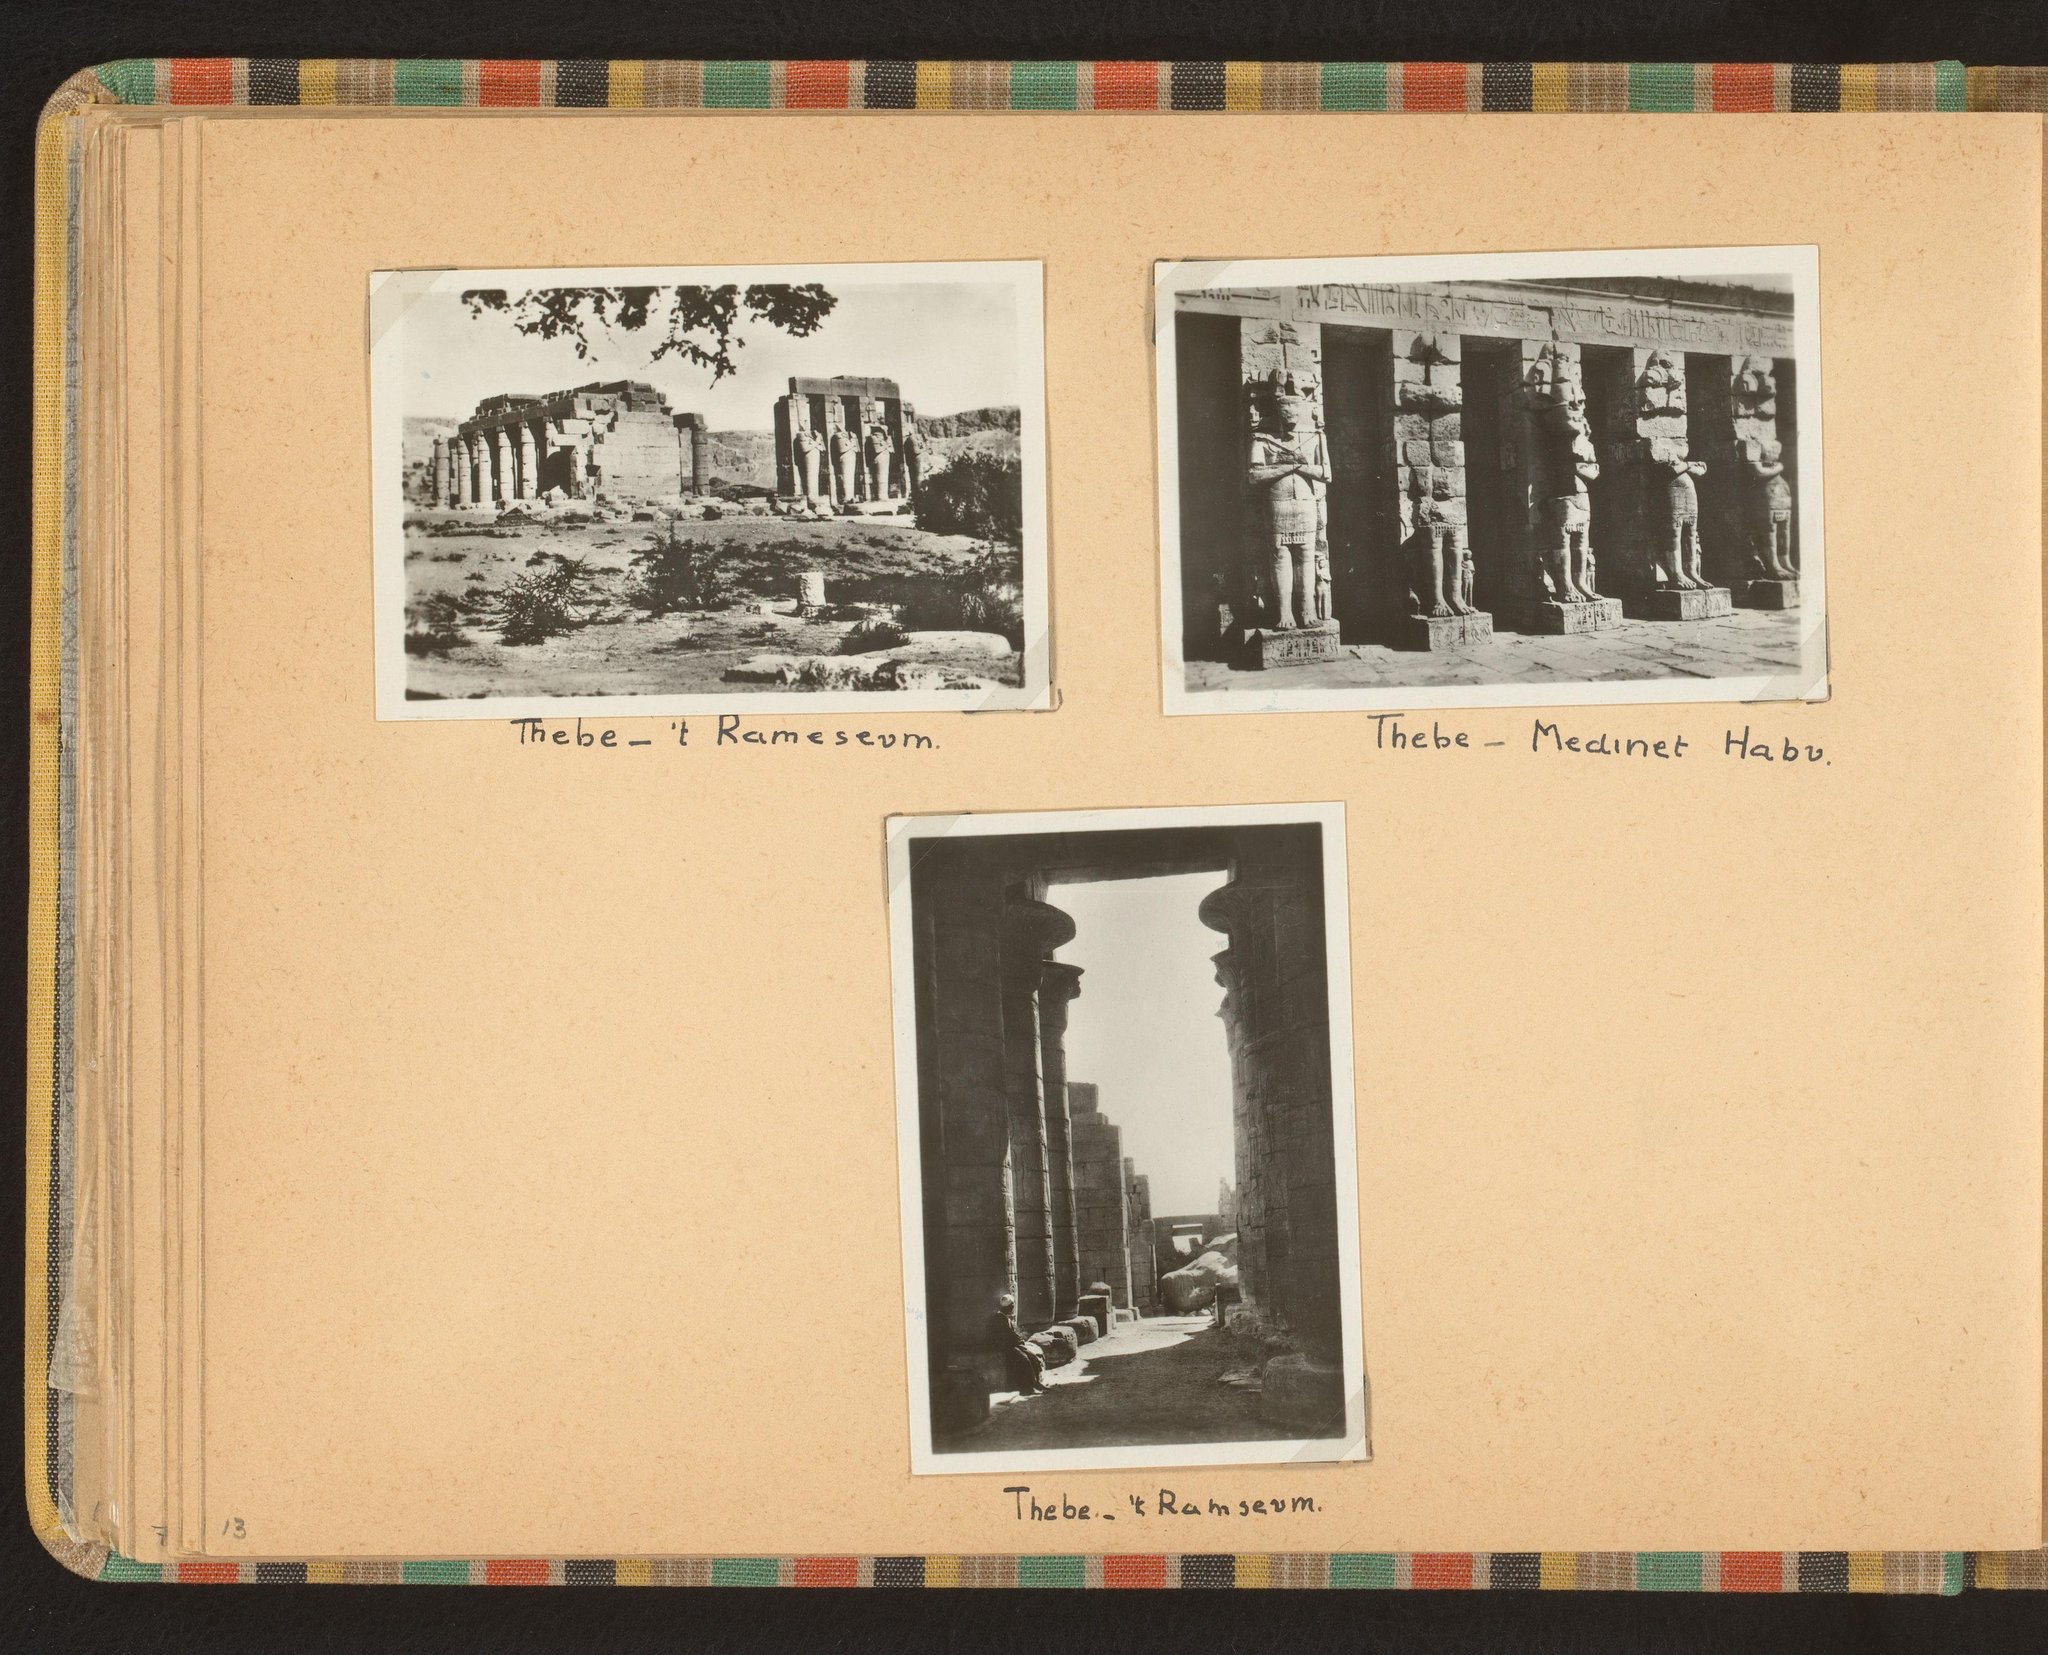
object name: photograph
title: Thebe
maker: Anonymous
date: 1936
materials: paper, photographic support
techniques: gelatin silver print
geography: egypt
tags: tourism, thebes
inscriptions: inscription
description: Albumblad met drie foto's van het Ramesseum en van de Tempel van Ramses III te Medinet Haboe. Onderdeel van een album over een vakantiereis over de Nijl in 1936.